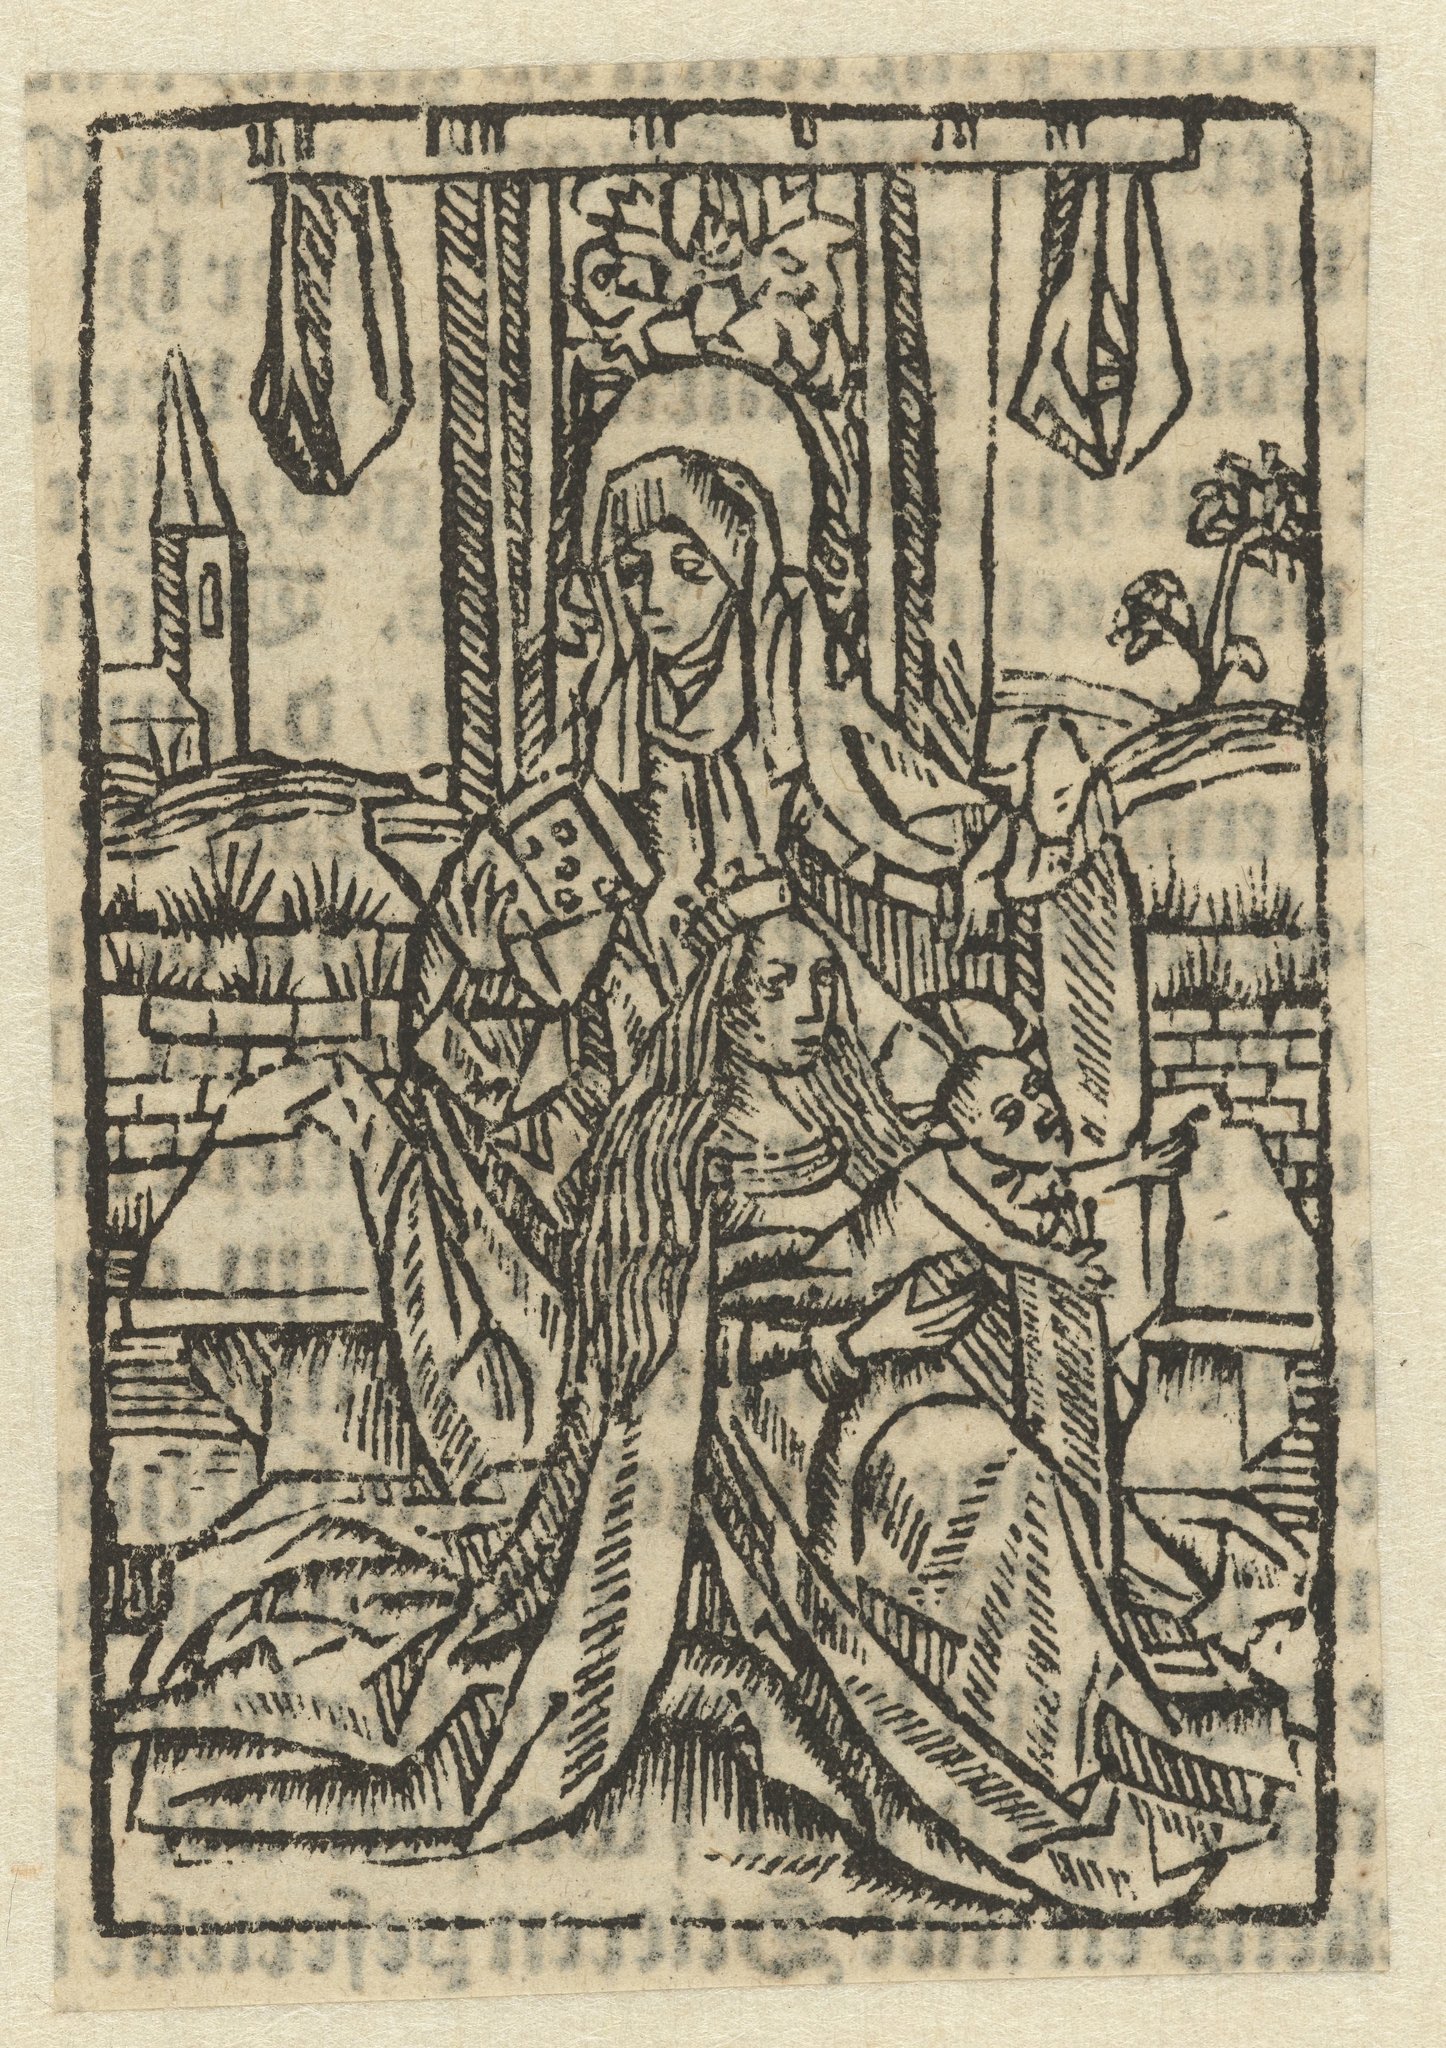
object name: print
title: Anna te Drieën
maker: Anonymous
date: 1604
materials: paper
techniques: woodcut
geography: low countries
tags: holy family with others, e.g.: anna, extended representations of 'anna selbdritt' (joseph and joachim, three husbands, three daughters with seven children)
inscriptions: collector's mark: Lugt 2228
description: Uitgeknipte houtsnede uit Historia Ecclesiastica, uitgegeven door Matthias Lambrechts te Antwerpen in 1604